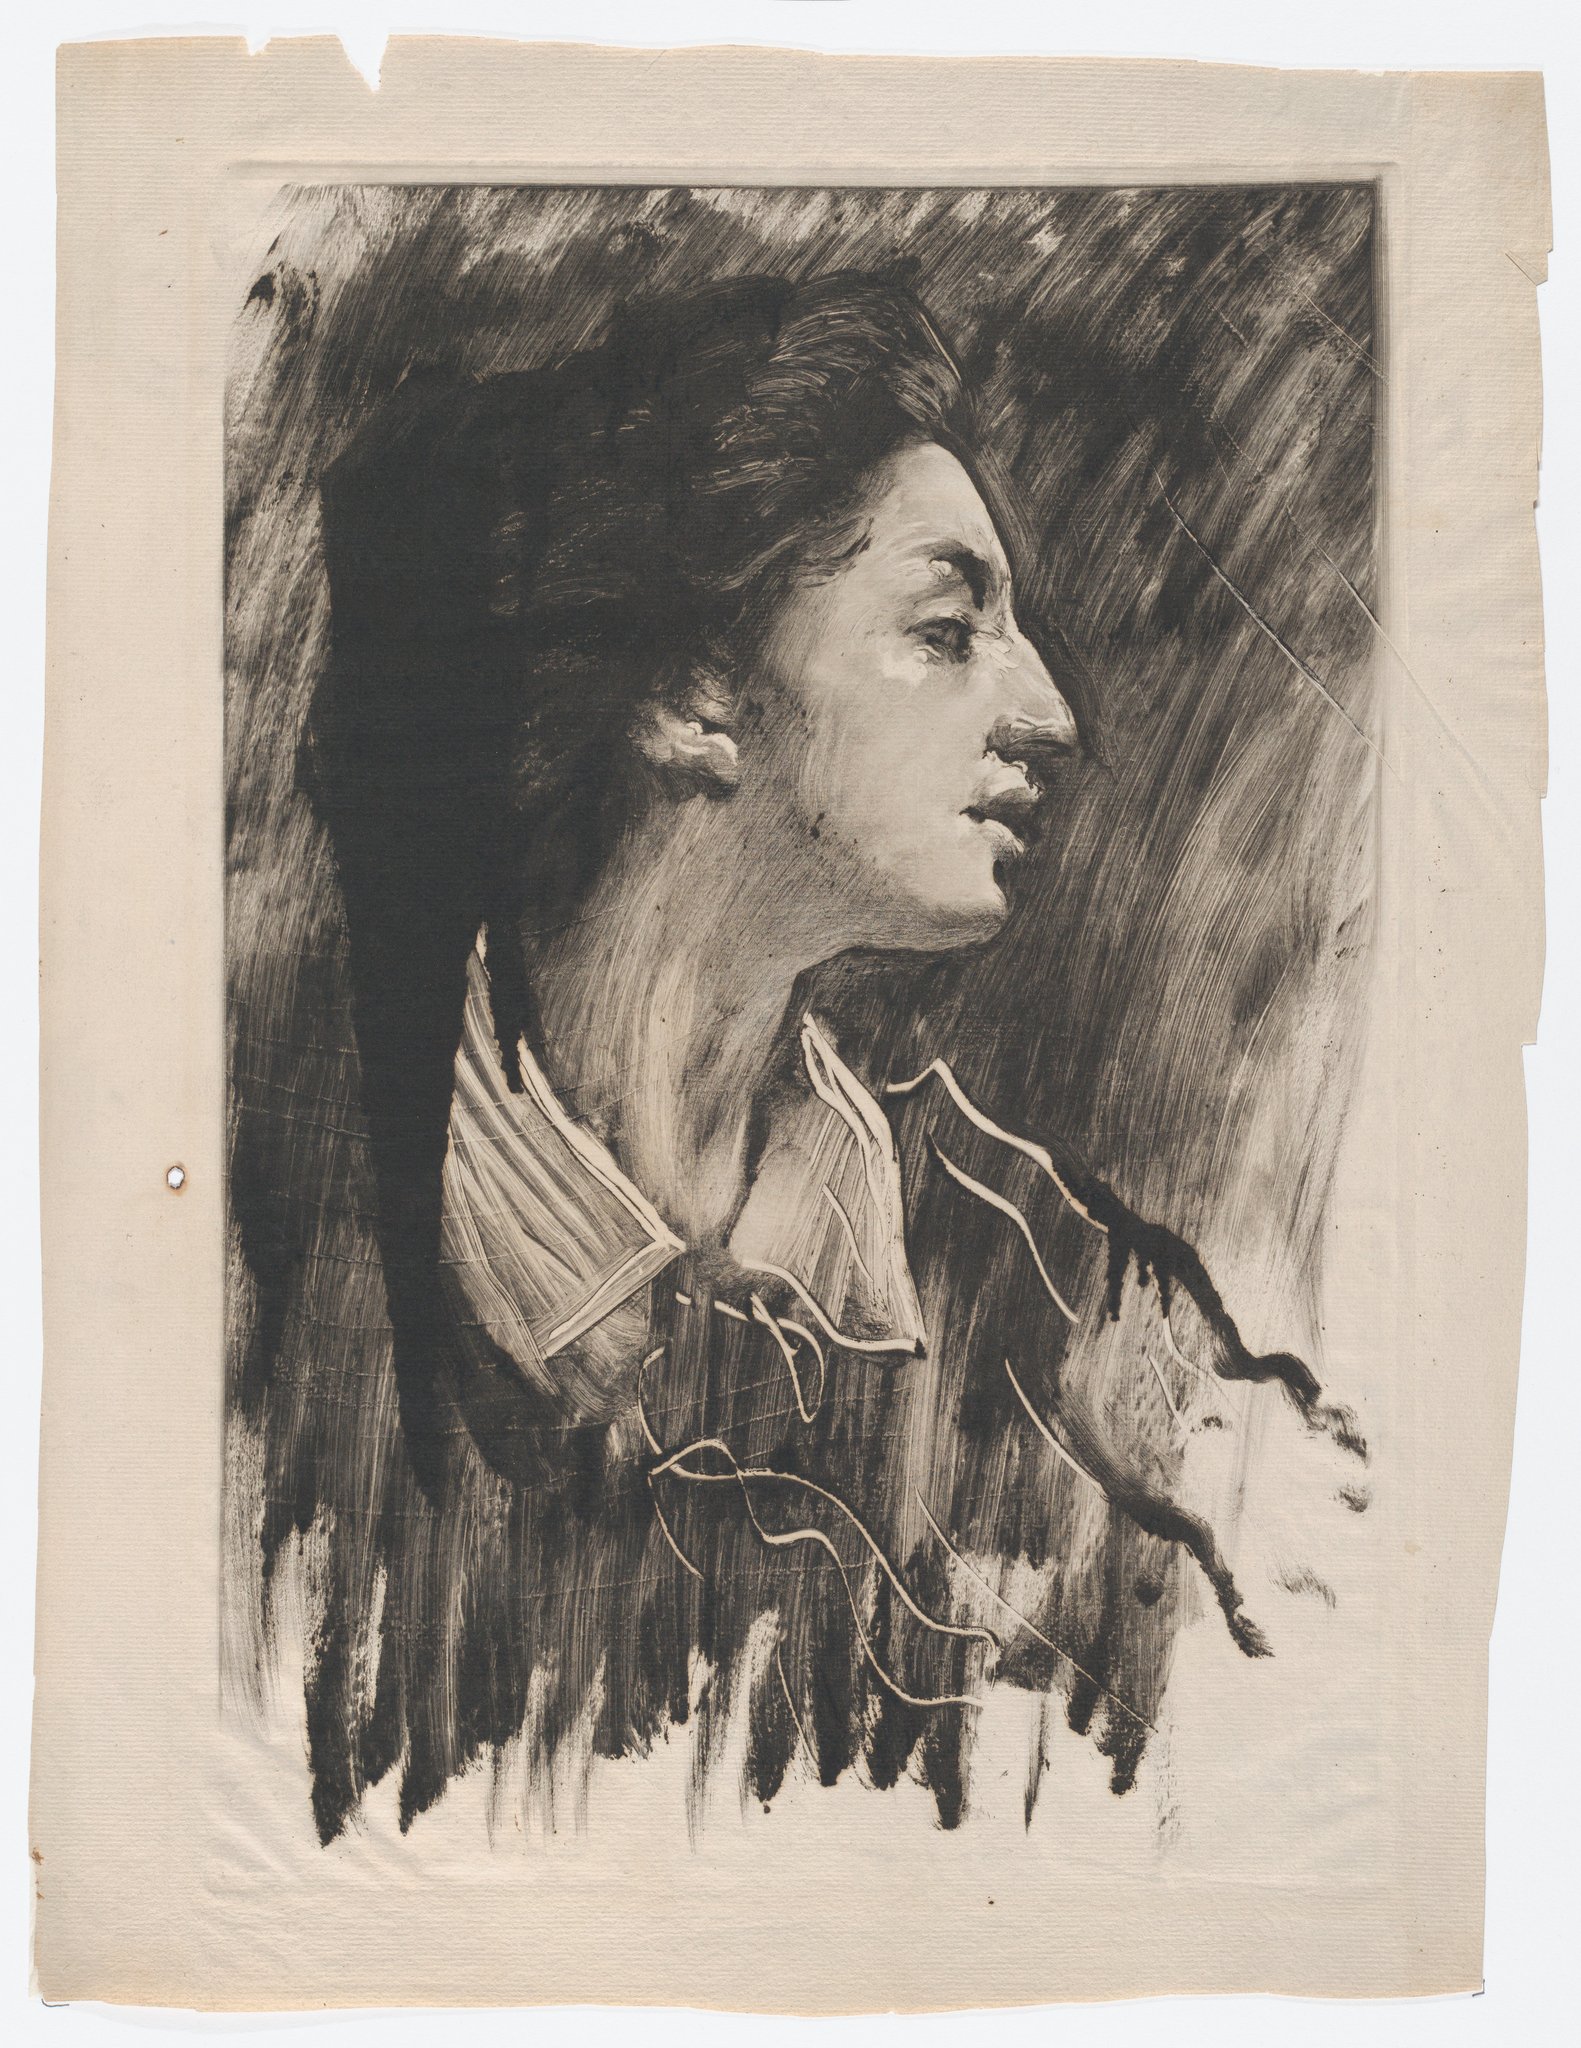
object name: print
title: Elizabeth Alexander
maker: john white alexander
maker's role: artist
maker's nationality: american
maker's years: 1856-1915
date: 1881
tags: profiles,women